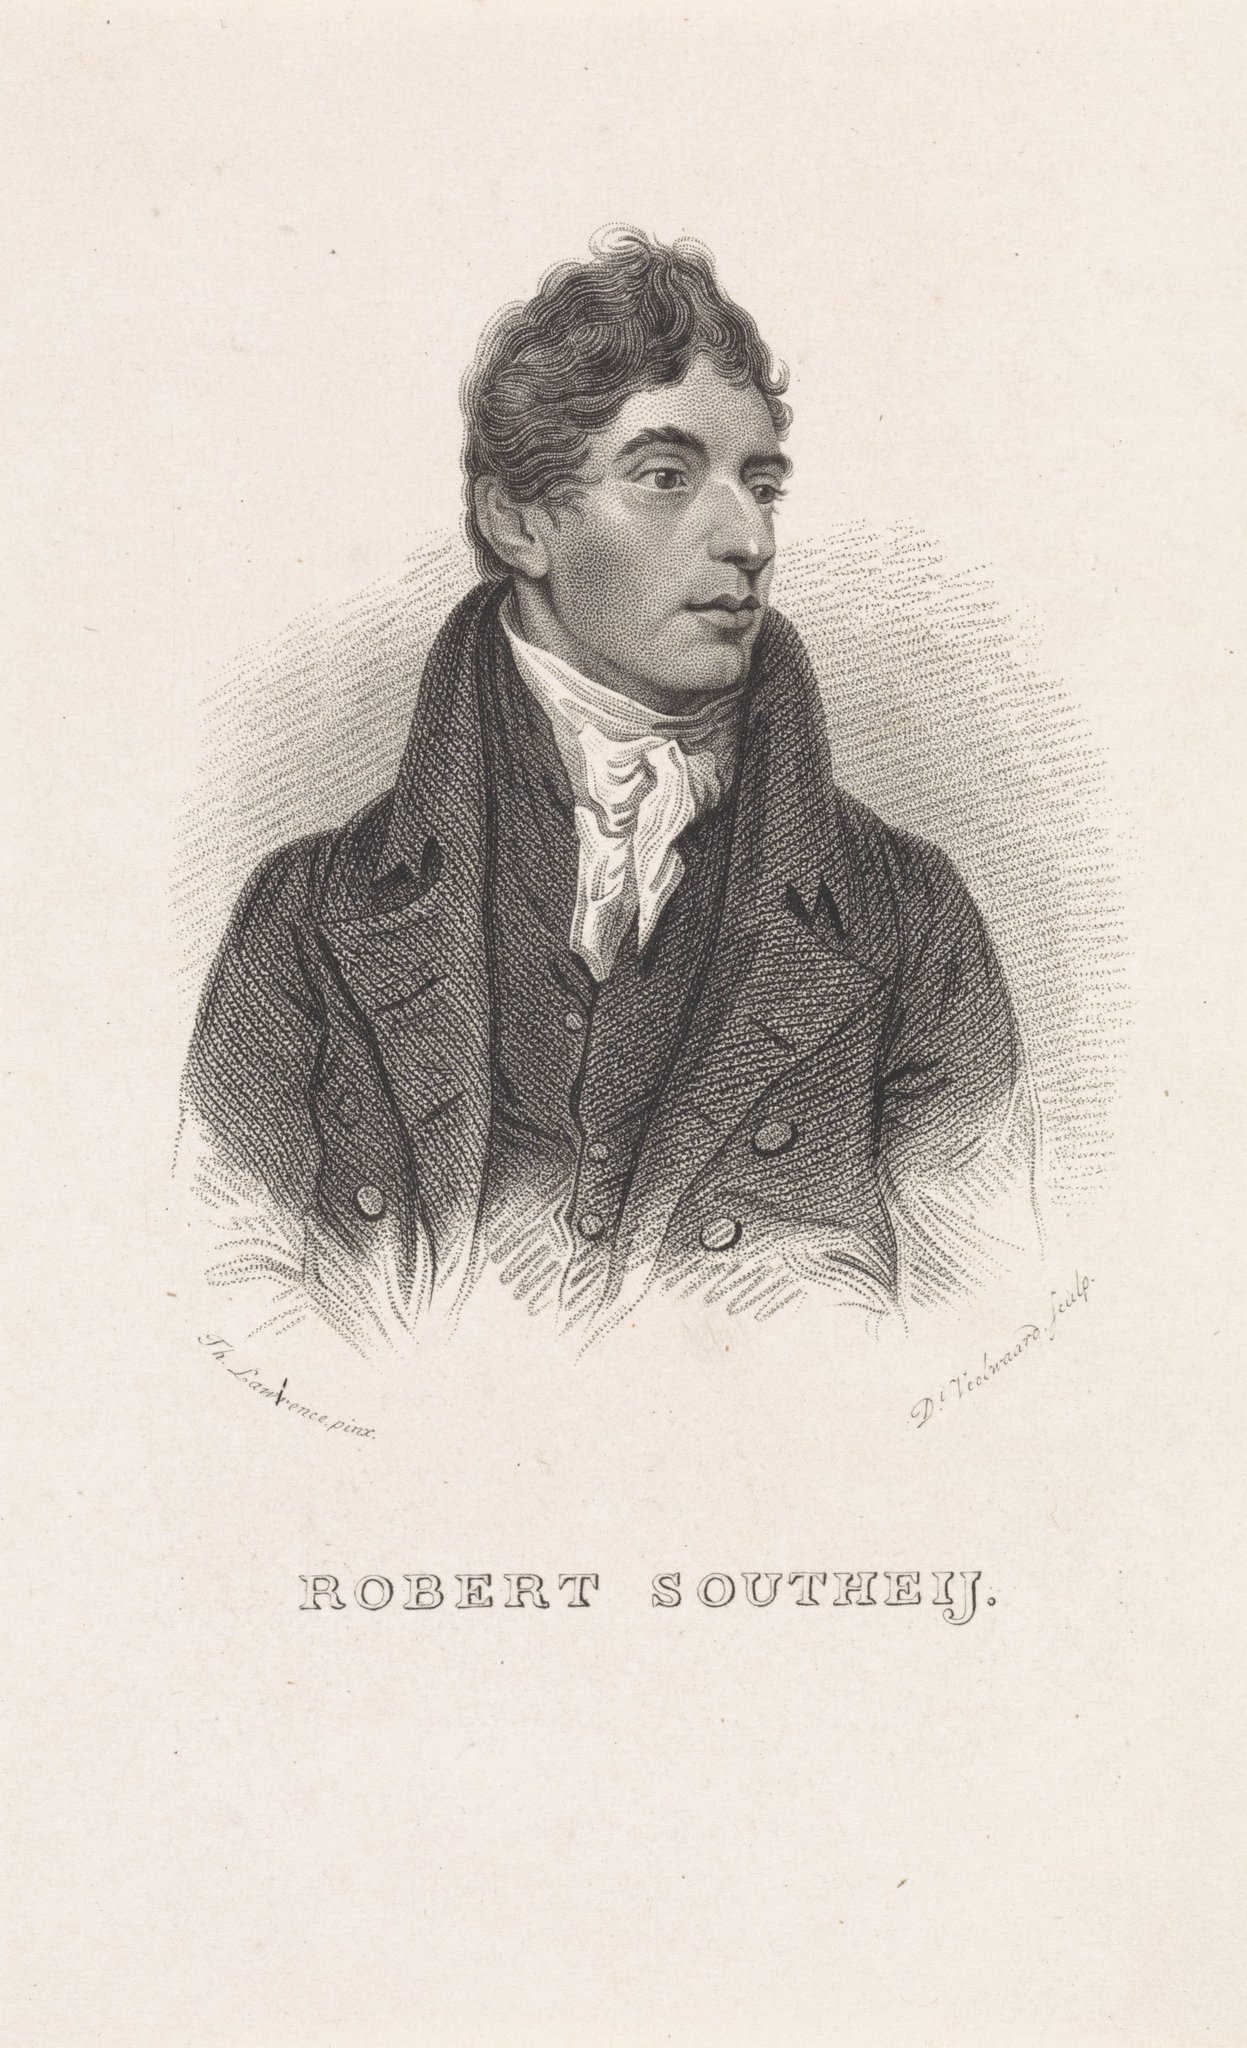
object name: print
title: Portret van de Engelse schrijver Robert Southey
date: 1828-1851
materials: paper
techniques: engraving, etching, roulette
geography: amsterdam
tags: robert southey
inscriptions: collector's mark: Lugt 2228